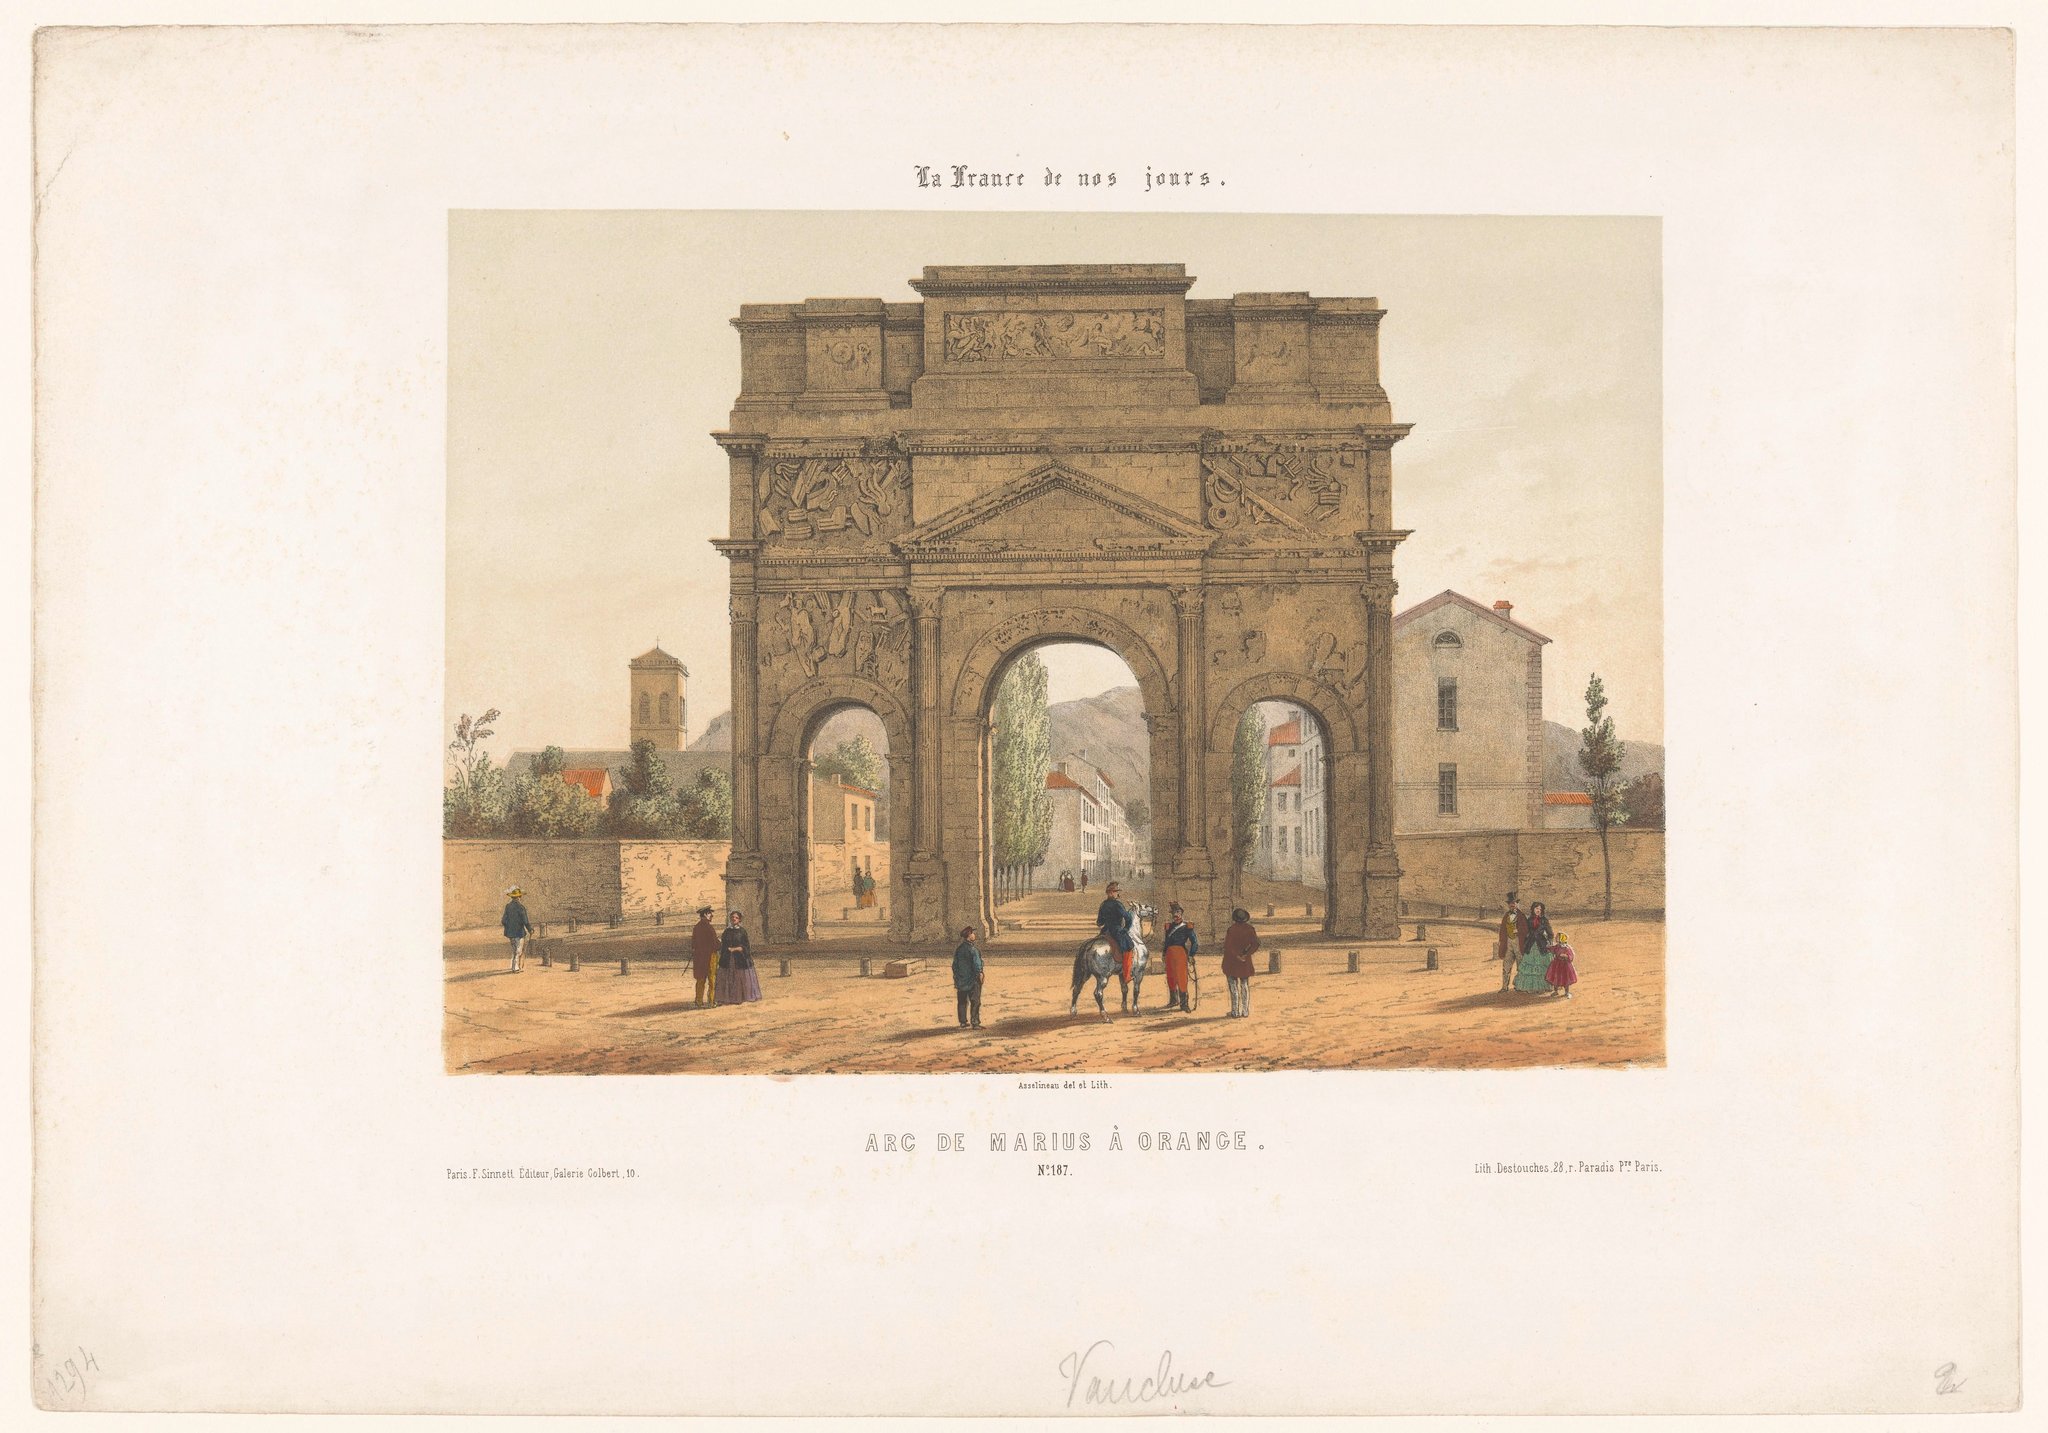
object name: print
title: Arc de Marius à Orange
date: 1856-1858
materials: paper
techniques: lithograph, hand coloring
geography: paris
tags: triumphal arch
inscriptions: annotation: ‘Vaucluse’, number: ‘1294’, collector's mark: Lugt 2228